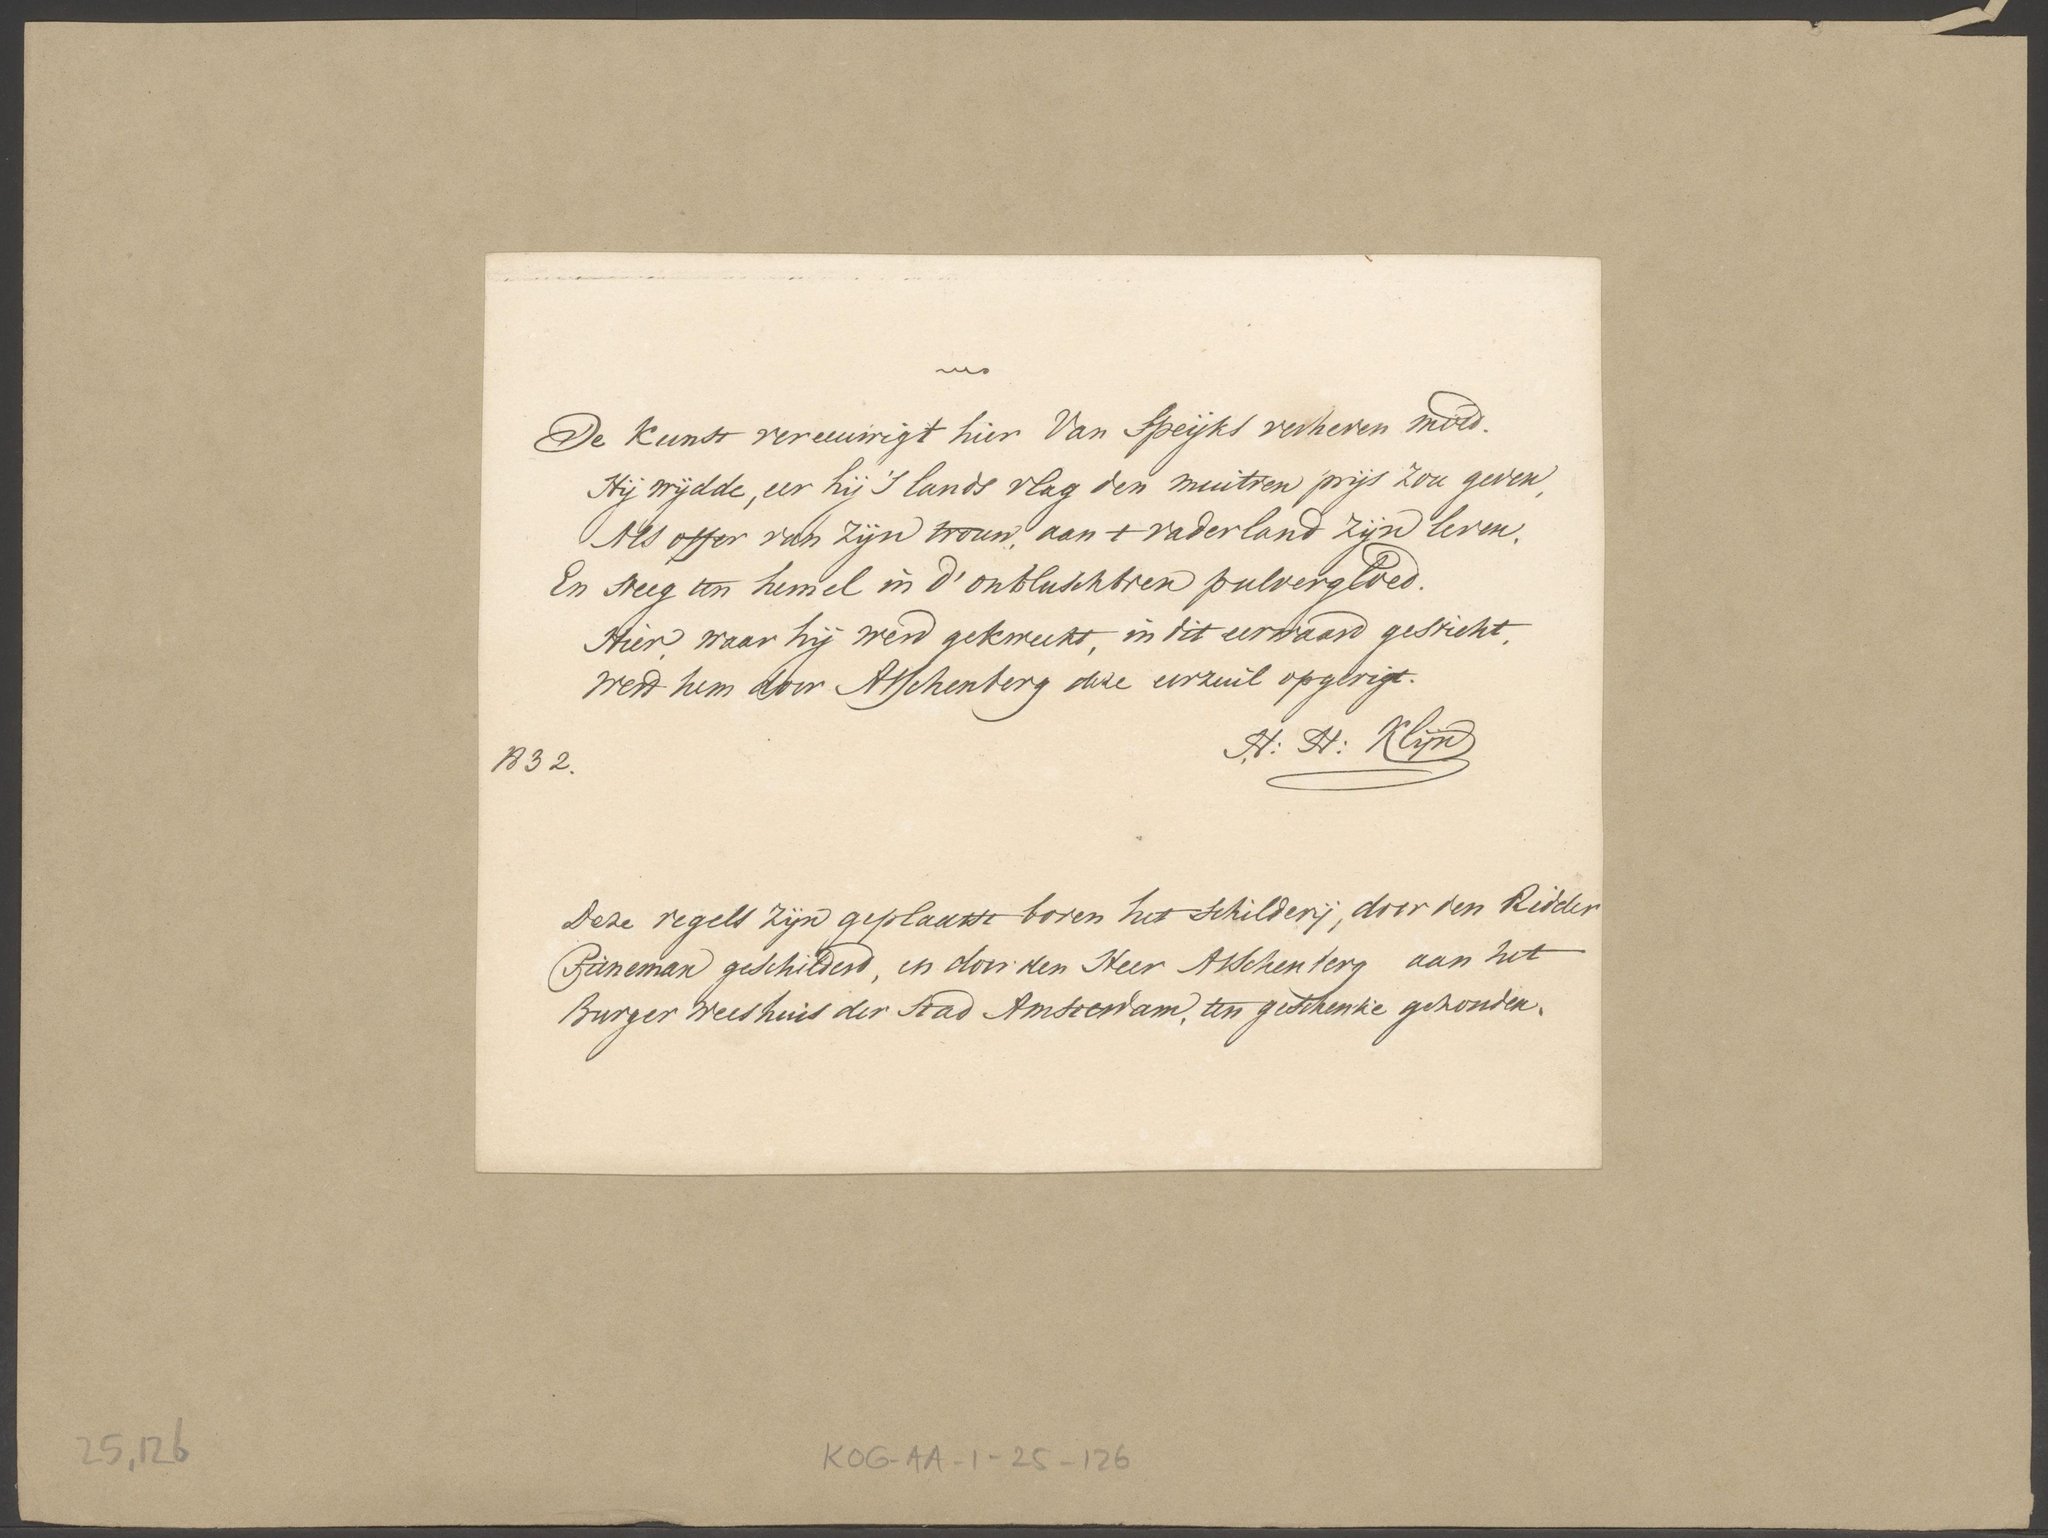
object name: print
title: Toelichting op schrift bij erezuil van Jan van Speyk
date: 1831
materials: paper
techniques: etching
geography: netherlands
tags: amsterdam, antwerp, jan van speyk, column (marking grave), epitaph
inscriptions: collector's mark: ‘25.126’ Lugt 1641b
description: Facsimile van handgeschreven tekst. Onderwerpsrubriek binnen de Atlas Amsterdam: Krijgswezen I: De Admiraliteit van Amsterdam, D. J.C. van Speyk.